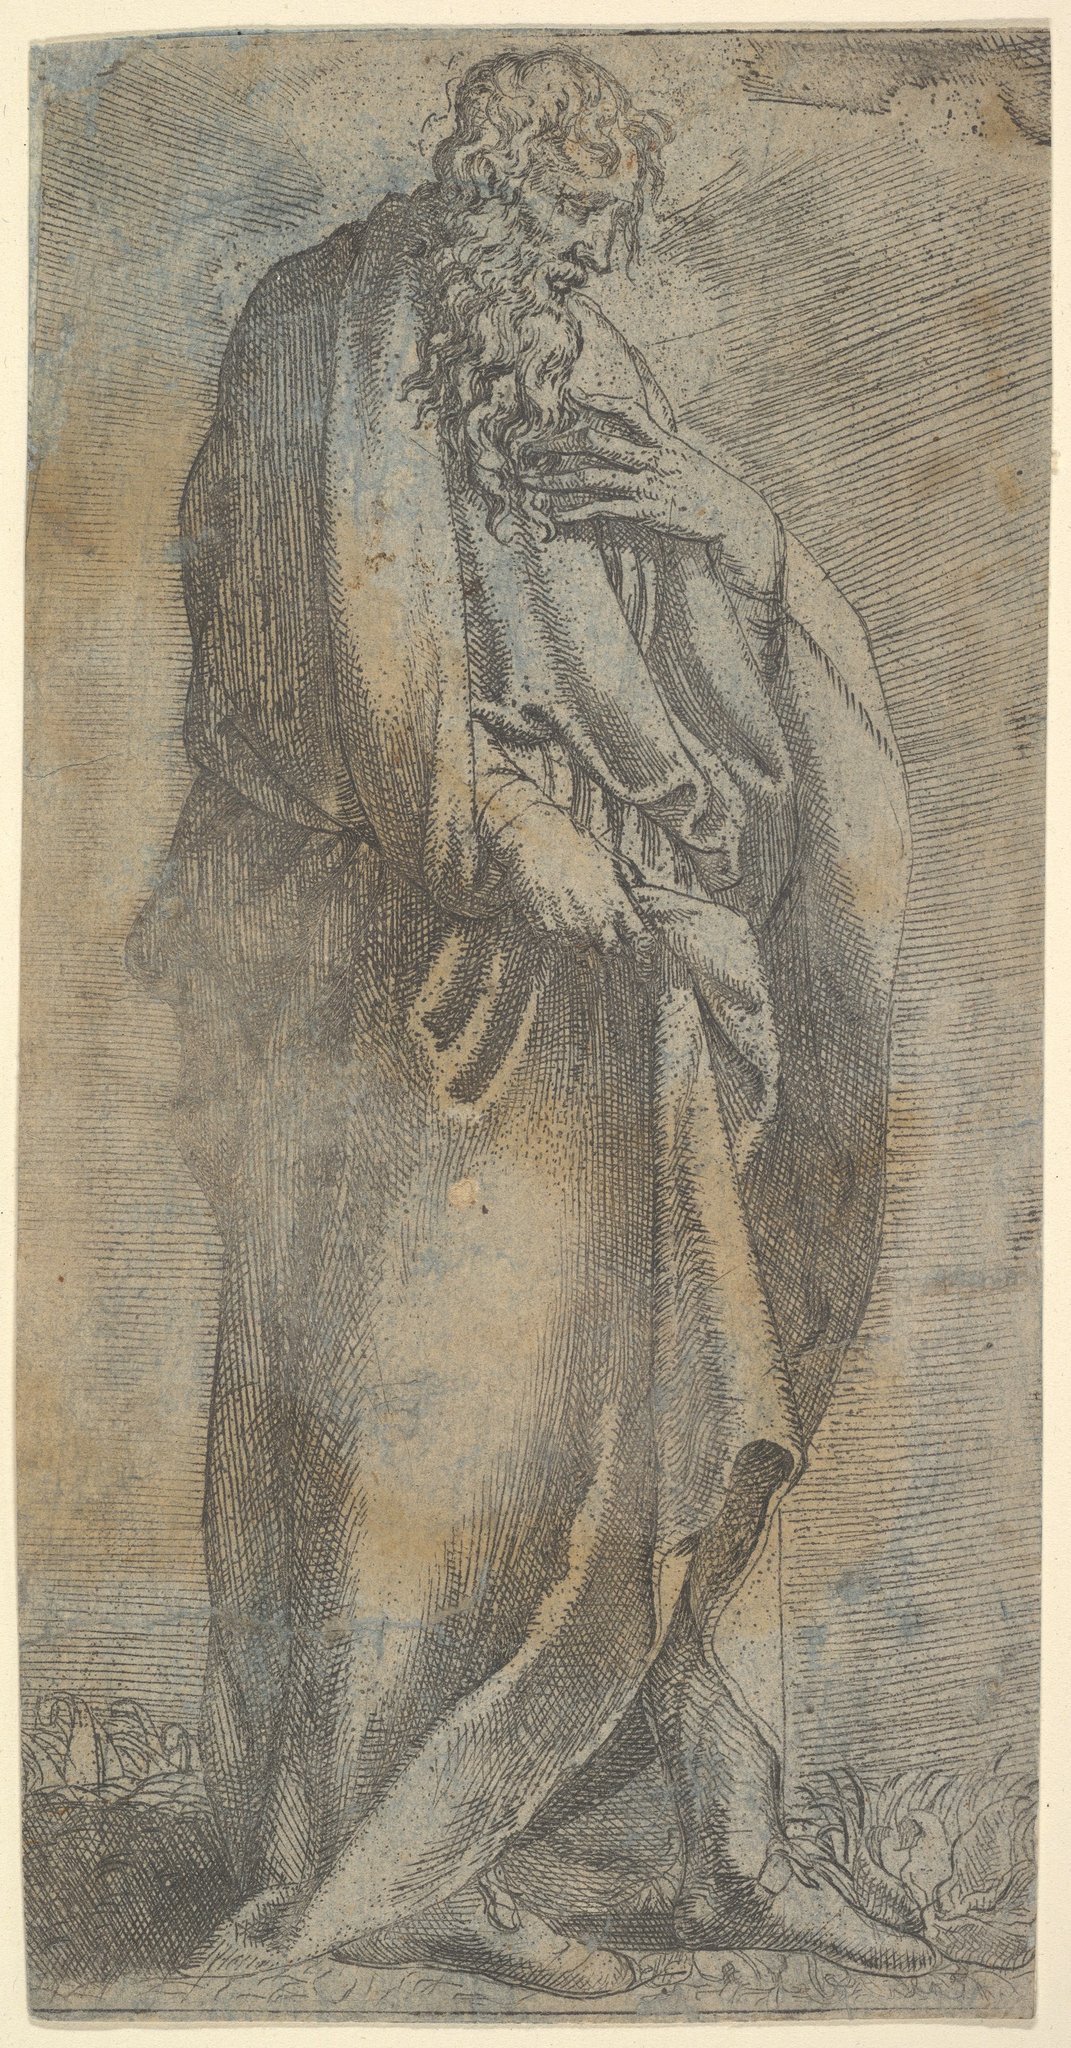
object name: print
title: Heavily draped male Figure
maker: anonymous, italian, 16th century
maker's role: artist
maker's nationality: italian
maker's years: 1500-1600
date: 1501-1600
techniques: etching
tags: men